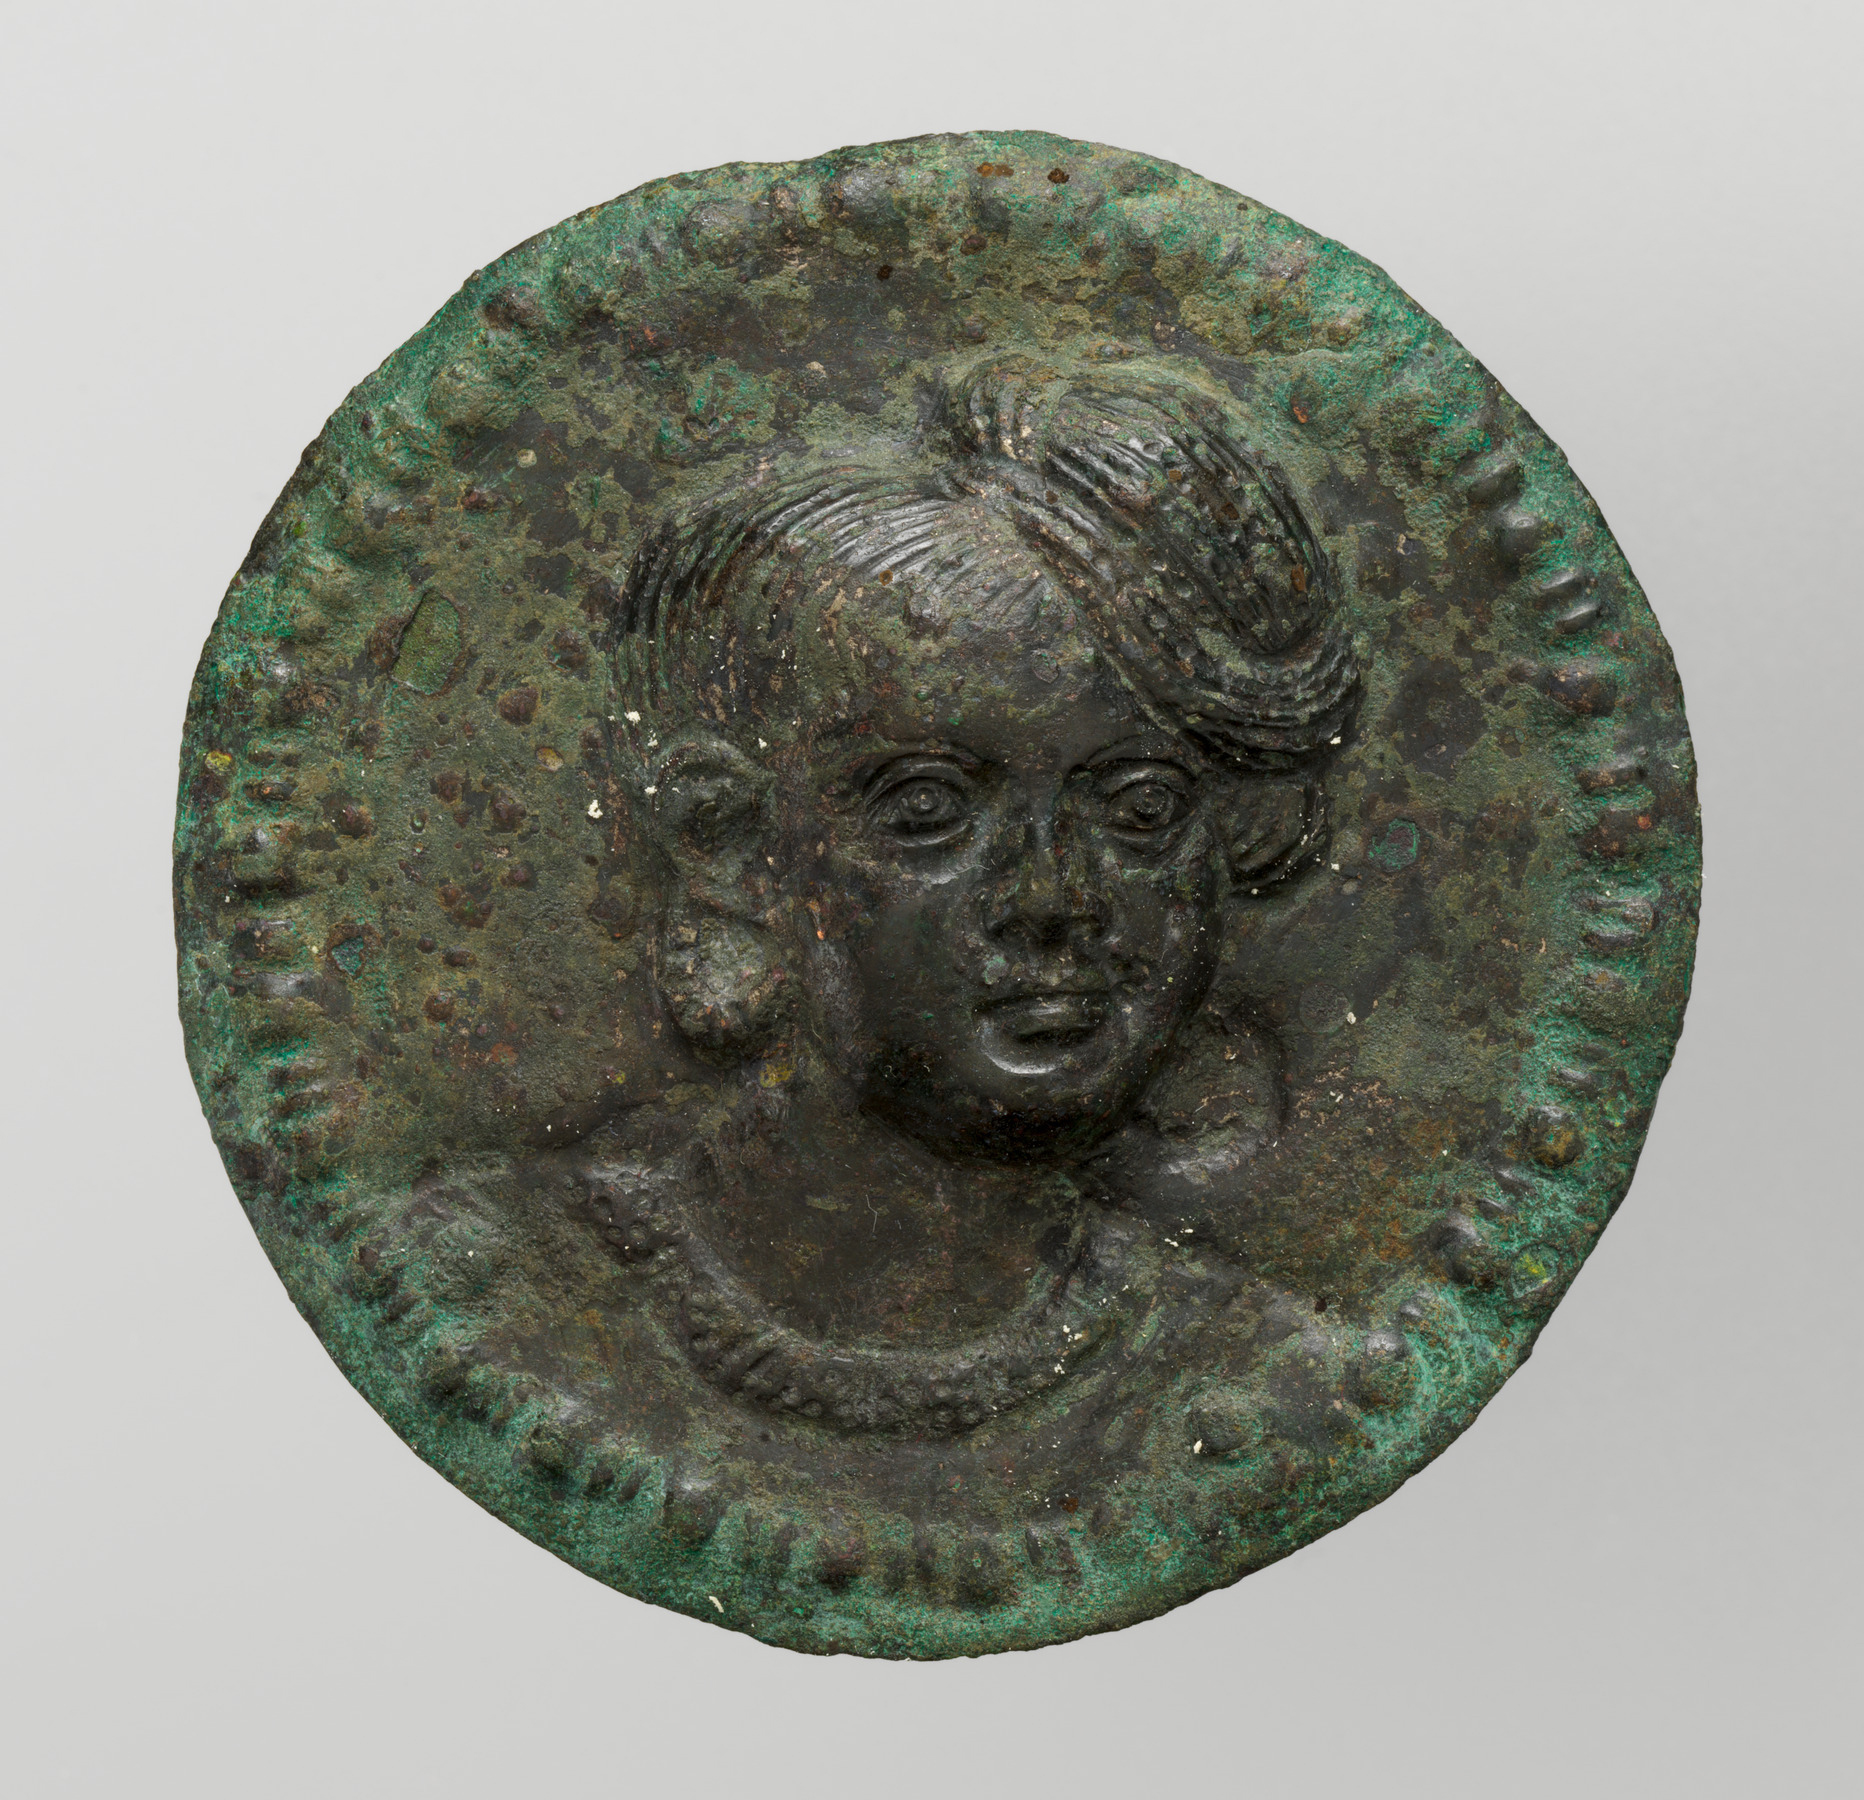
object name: medallion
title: One of a pair of medallions with portrait busts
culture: indian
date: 1-100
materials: alloy, copper, nickel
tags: gandhara,men